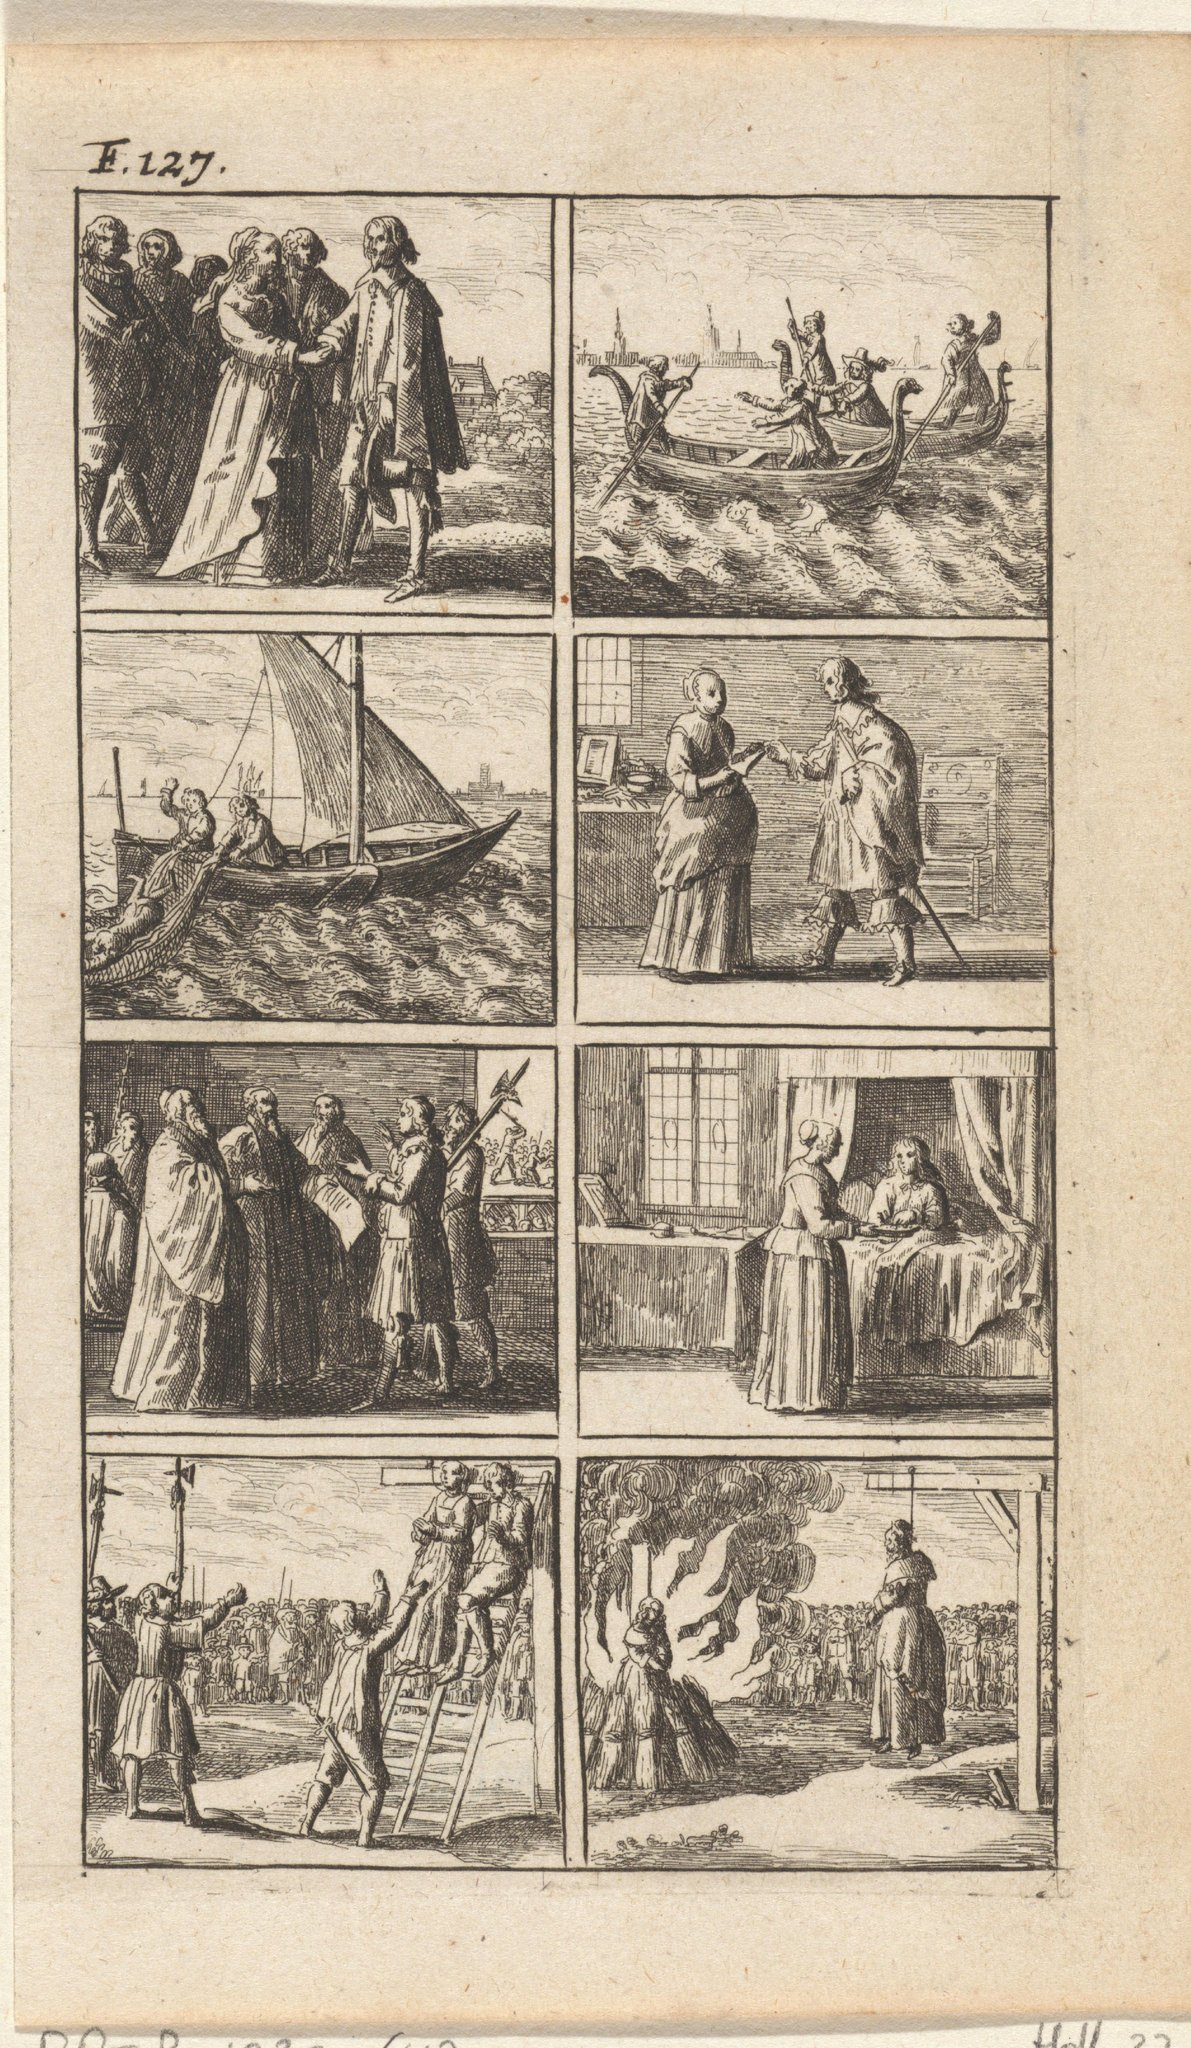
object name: print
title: Verhaal met voorstellingen van moord en doodstraf (F. 127.)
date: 1667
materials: paper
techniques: etching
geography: amsterdam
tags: death penalty, execution, murder, fighting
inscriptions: collector's mark: Lugt 2166, collector's mark: Lugt 2760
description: Verhaal in acht scènes met enkele voorstellingen van moord en doodstraf. Onder andere van een man die overboord wordt gegooid, enkele mensen aan een galg en van een vrouw op een brandstapel. Linksboven: F. 127.